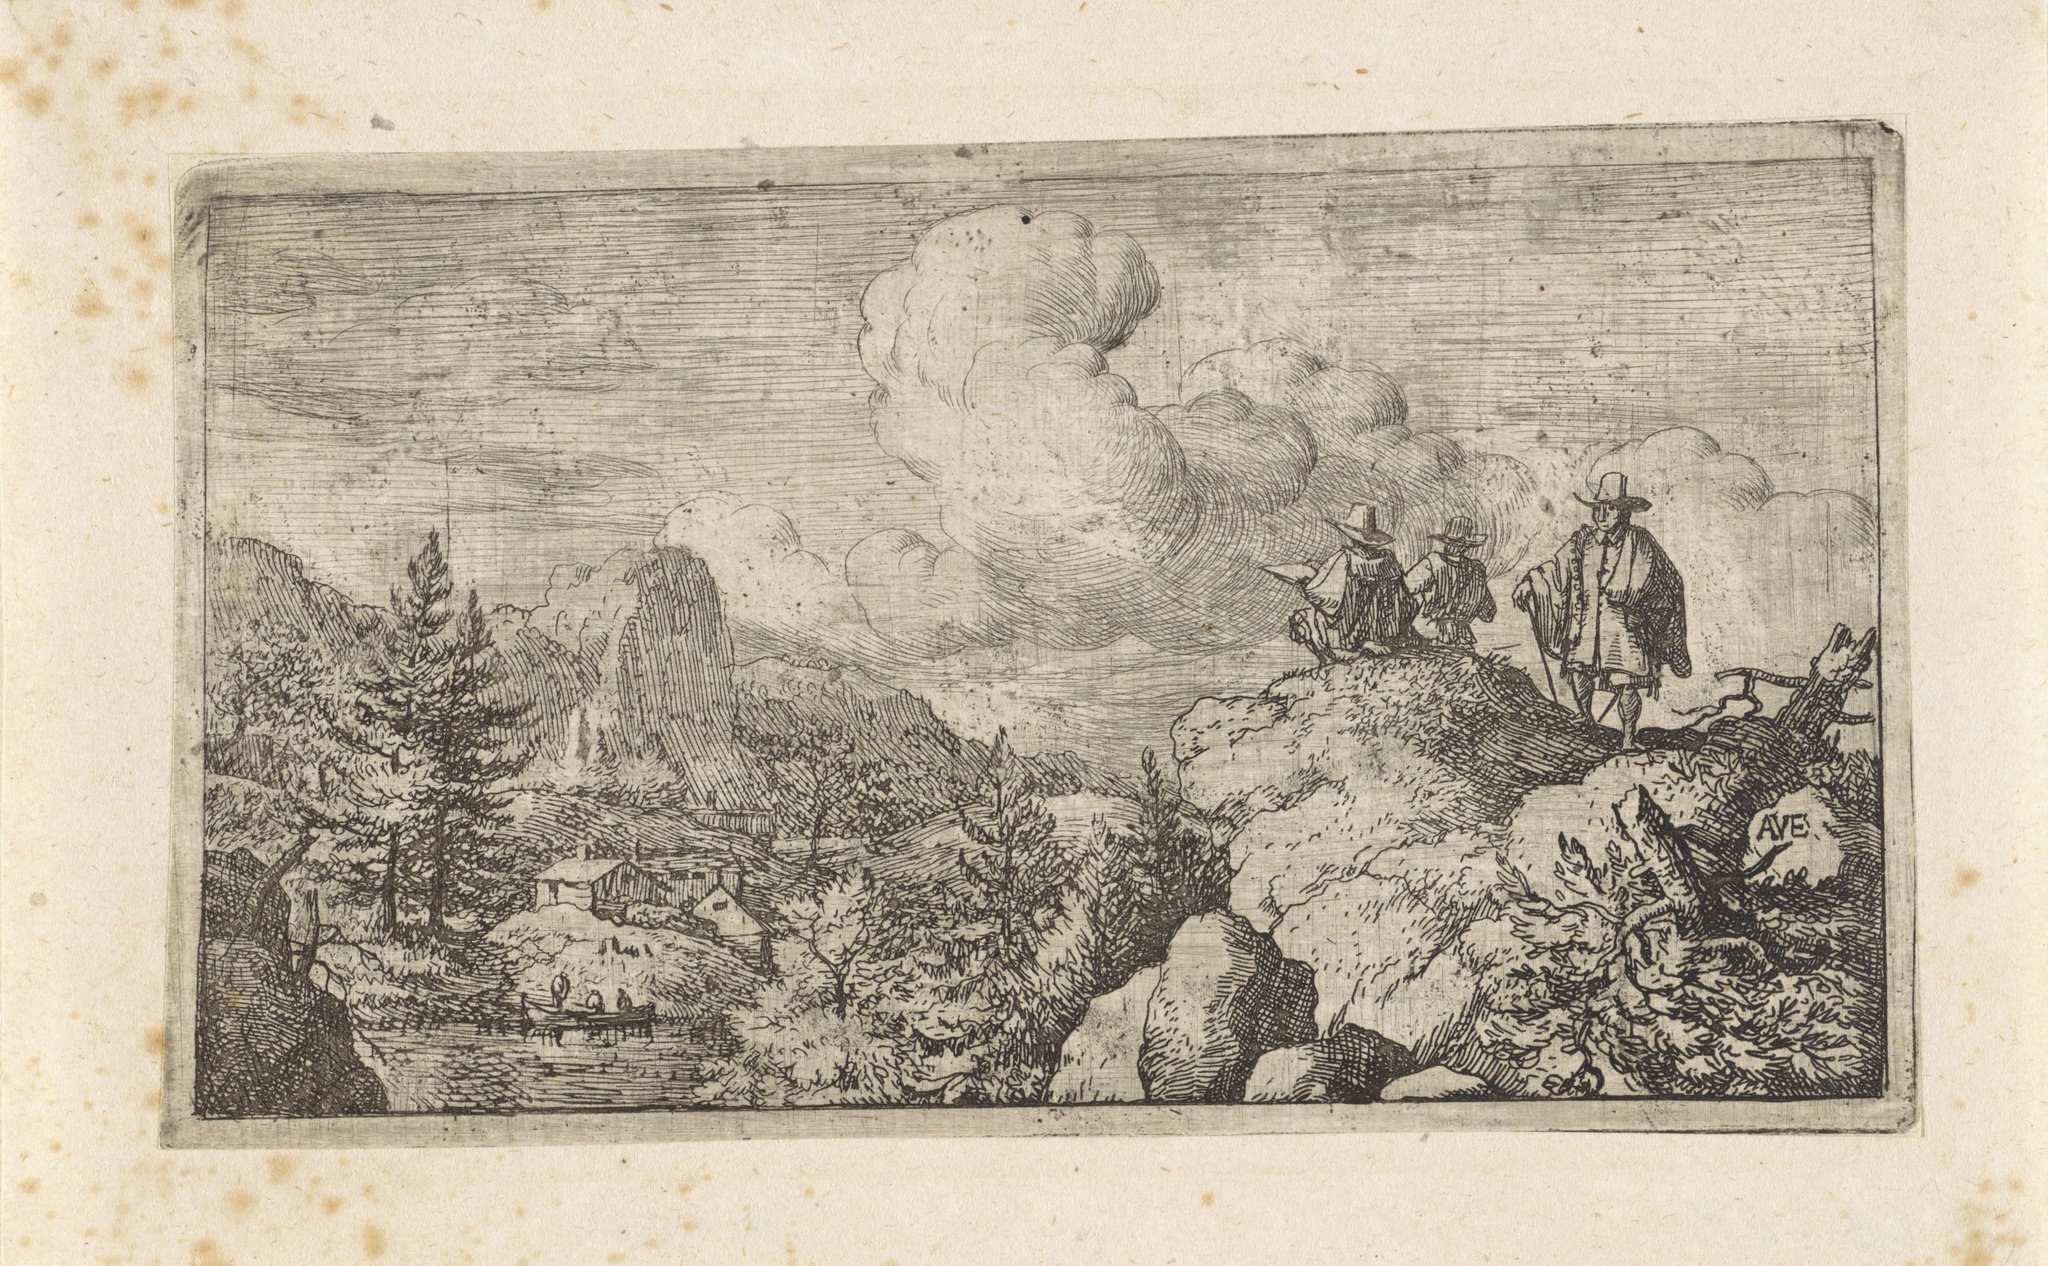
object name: print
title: Landschap met tekenaars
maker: allaert van everdingen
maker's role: draughtsman, painter, print maker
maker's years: 1621-1675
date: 1651-1675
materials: paper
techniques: etching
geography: netherlands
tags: mountains (+ landscape with figures, staffage)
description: Berglandschap met op de voorgrond drie mannen, waarvan er één een schetsboek in handen heeft.